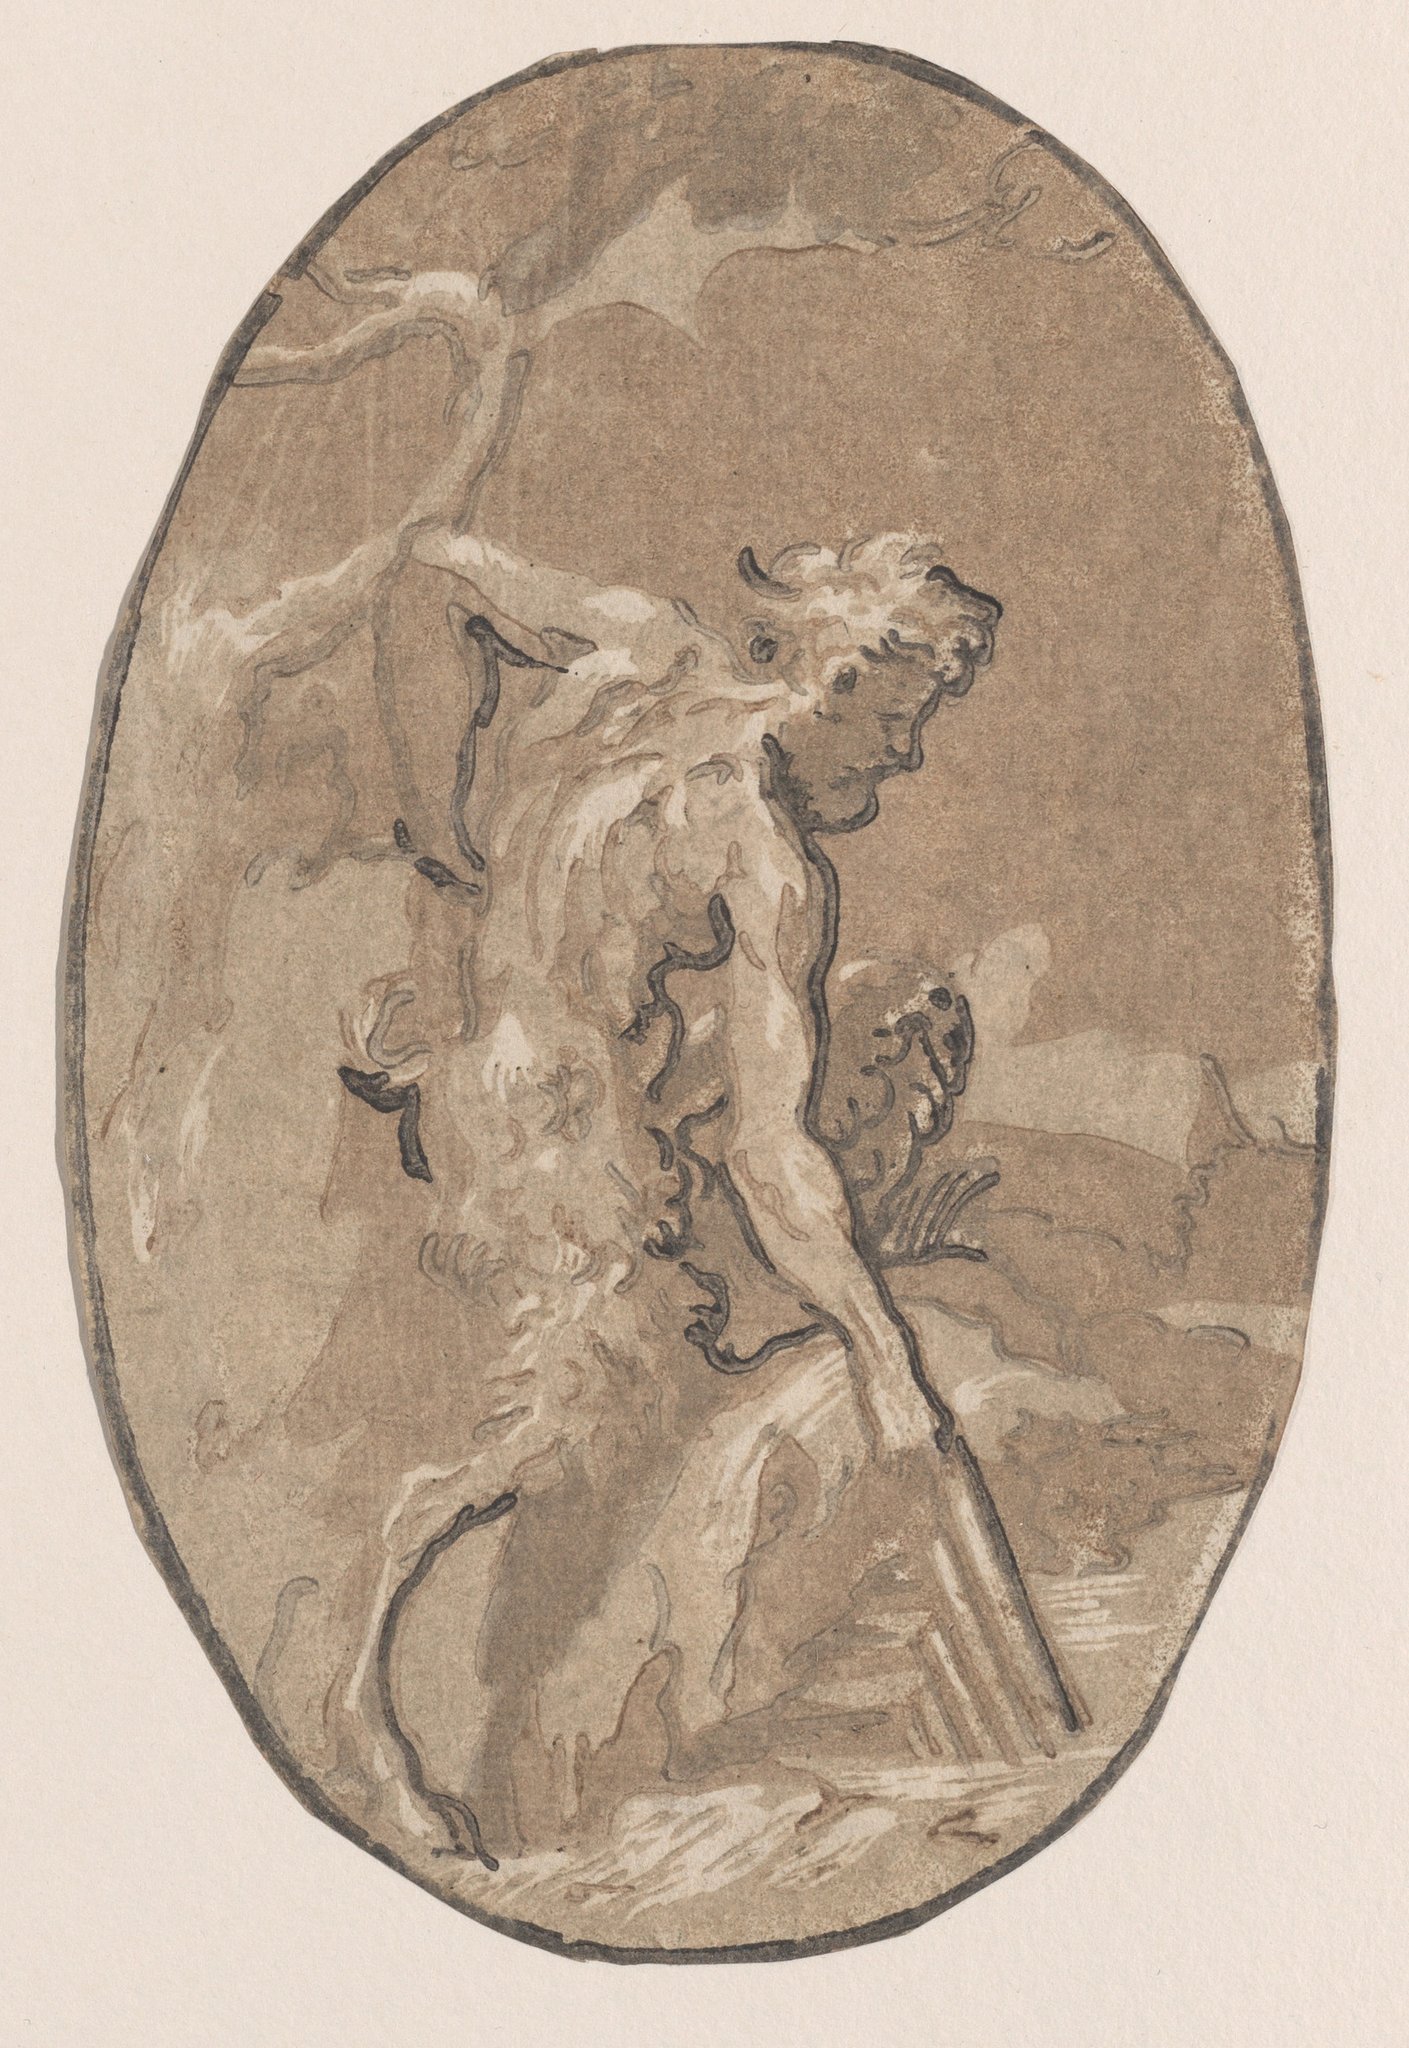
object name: print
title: Marsyas drawing the Syrinx from the river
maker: niccolò vicentino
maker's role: artist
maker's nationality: italian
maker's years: 1510-1550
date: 1540-1550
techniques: woodcut